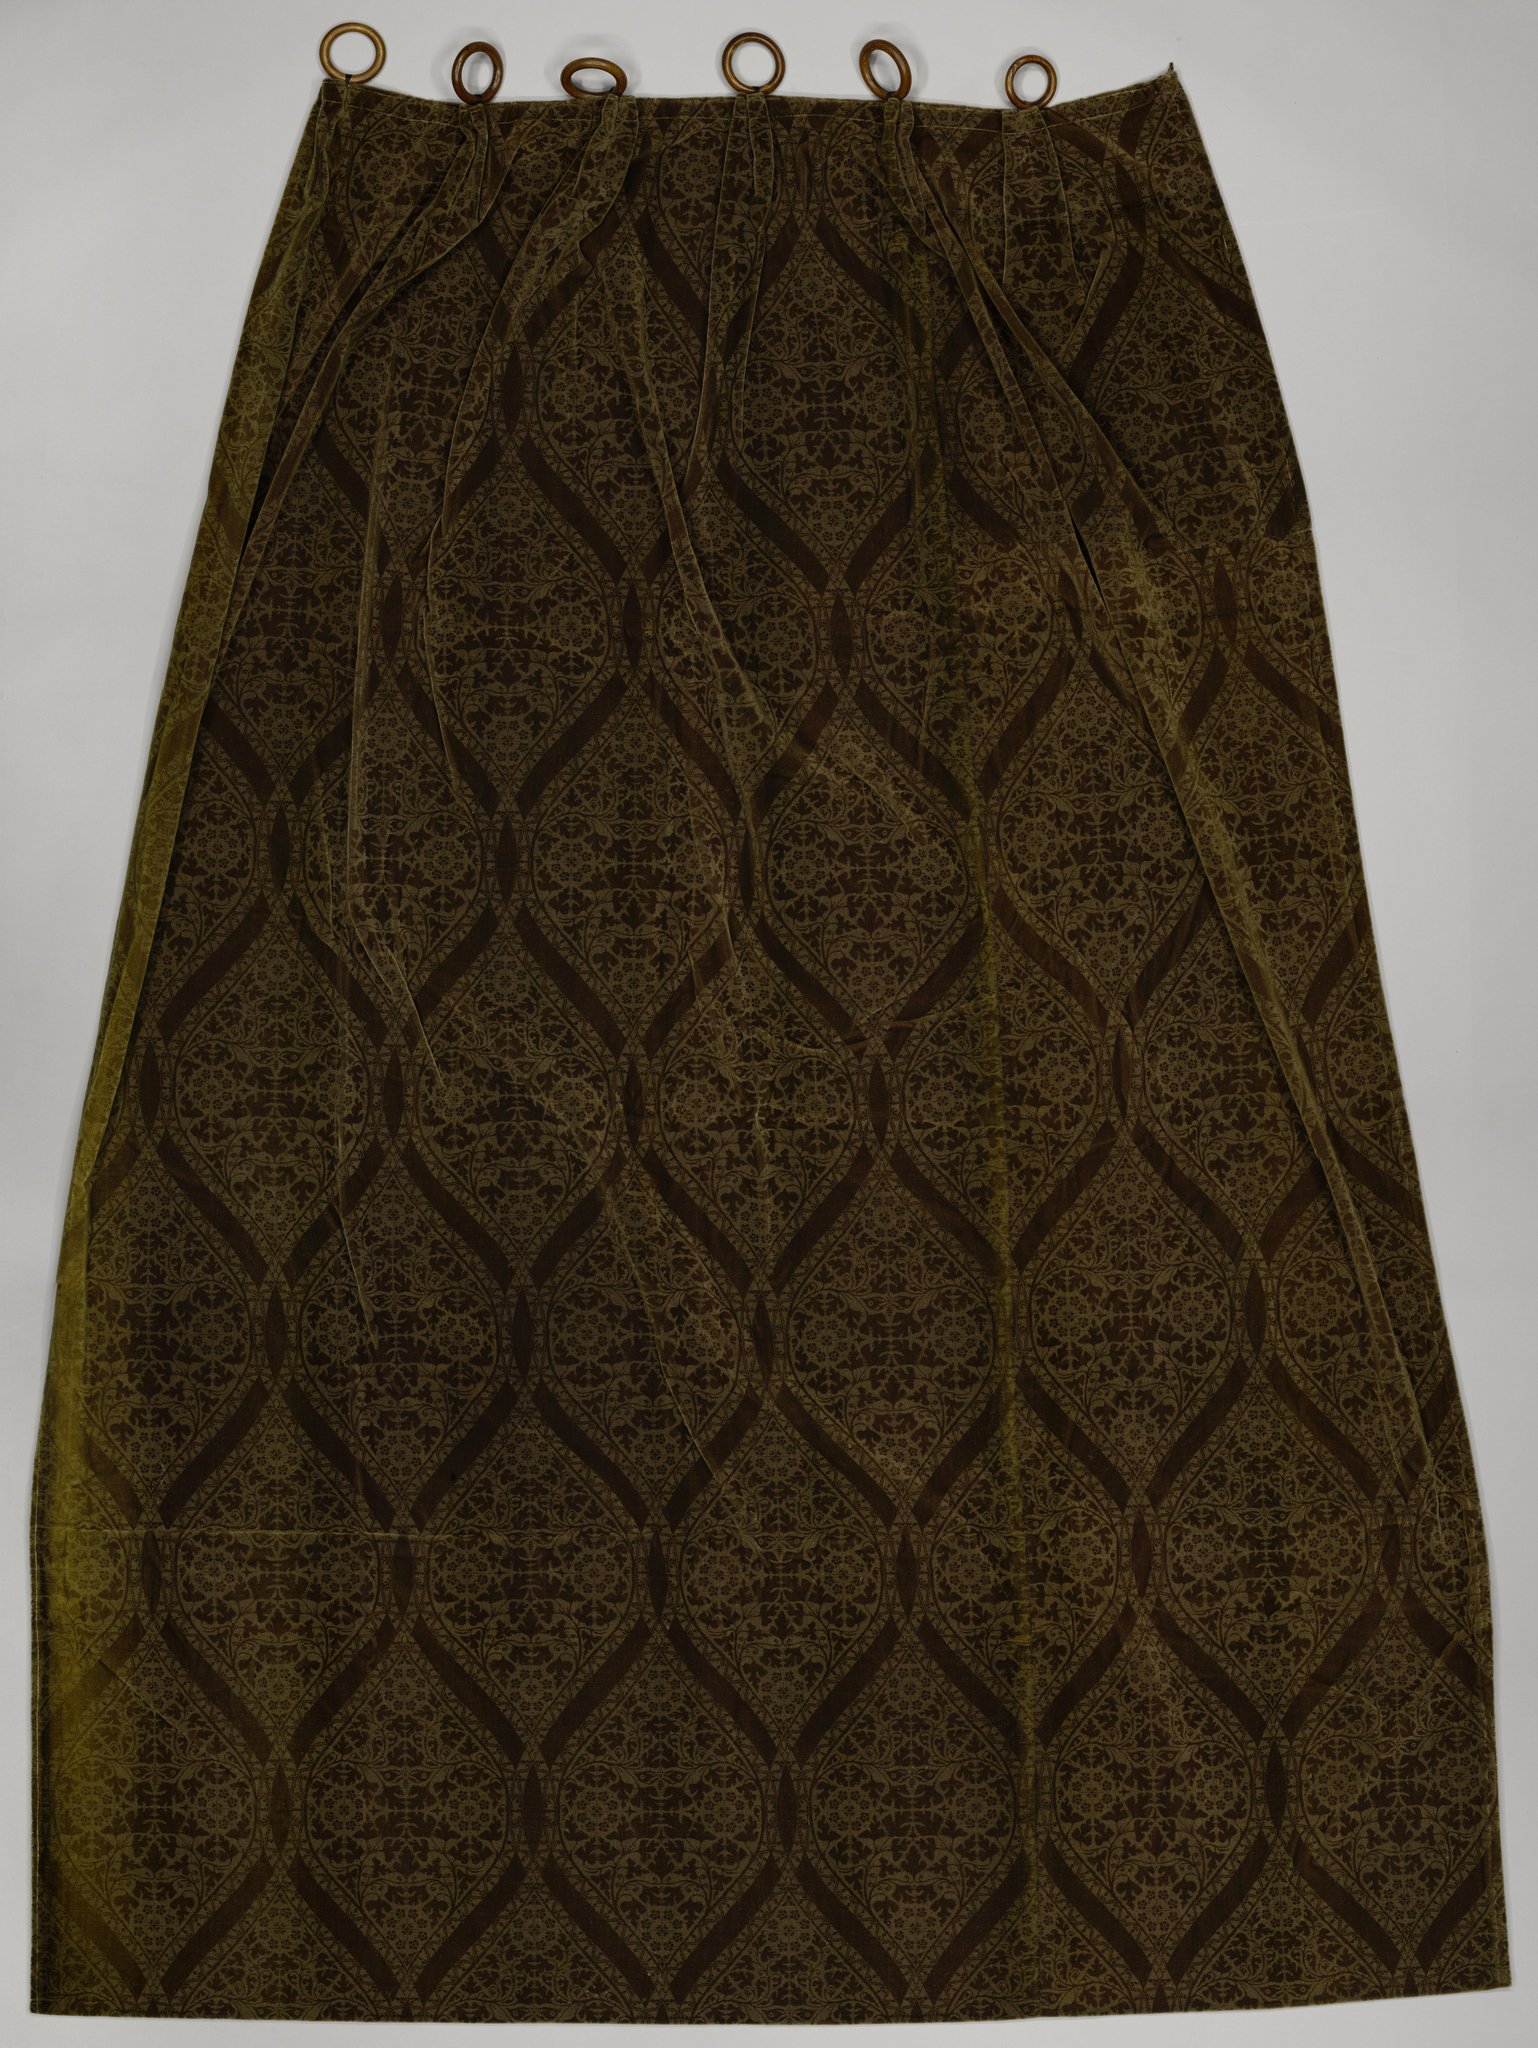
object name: curtain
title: Twee gordijnen van bruine trijp met dessin "Meiranken"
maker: theo nieuwenhuis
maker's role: designer, draughtsman, print maker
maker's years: 1866-1951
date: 1909-1920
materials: cotton, textile, hair, wood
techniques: velvet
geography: hengelo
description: Gordijnen van bruine trijp (velours frisé) met dessin "Meiranken", bestaande uit een vlinder, bladranken en bloemenkranzen binnen spitsovalen. Voorzien van zes houten gordijnringen. Vermoedelijk gerelateerd aan V-69771 en V-69757.